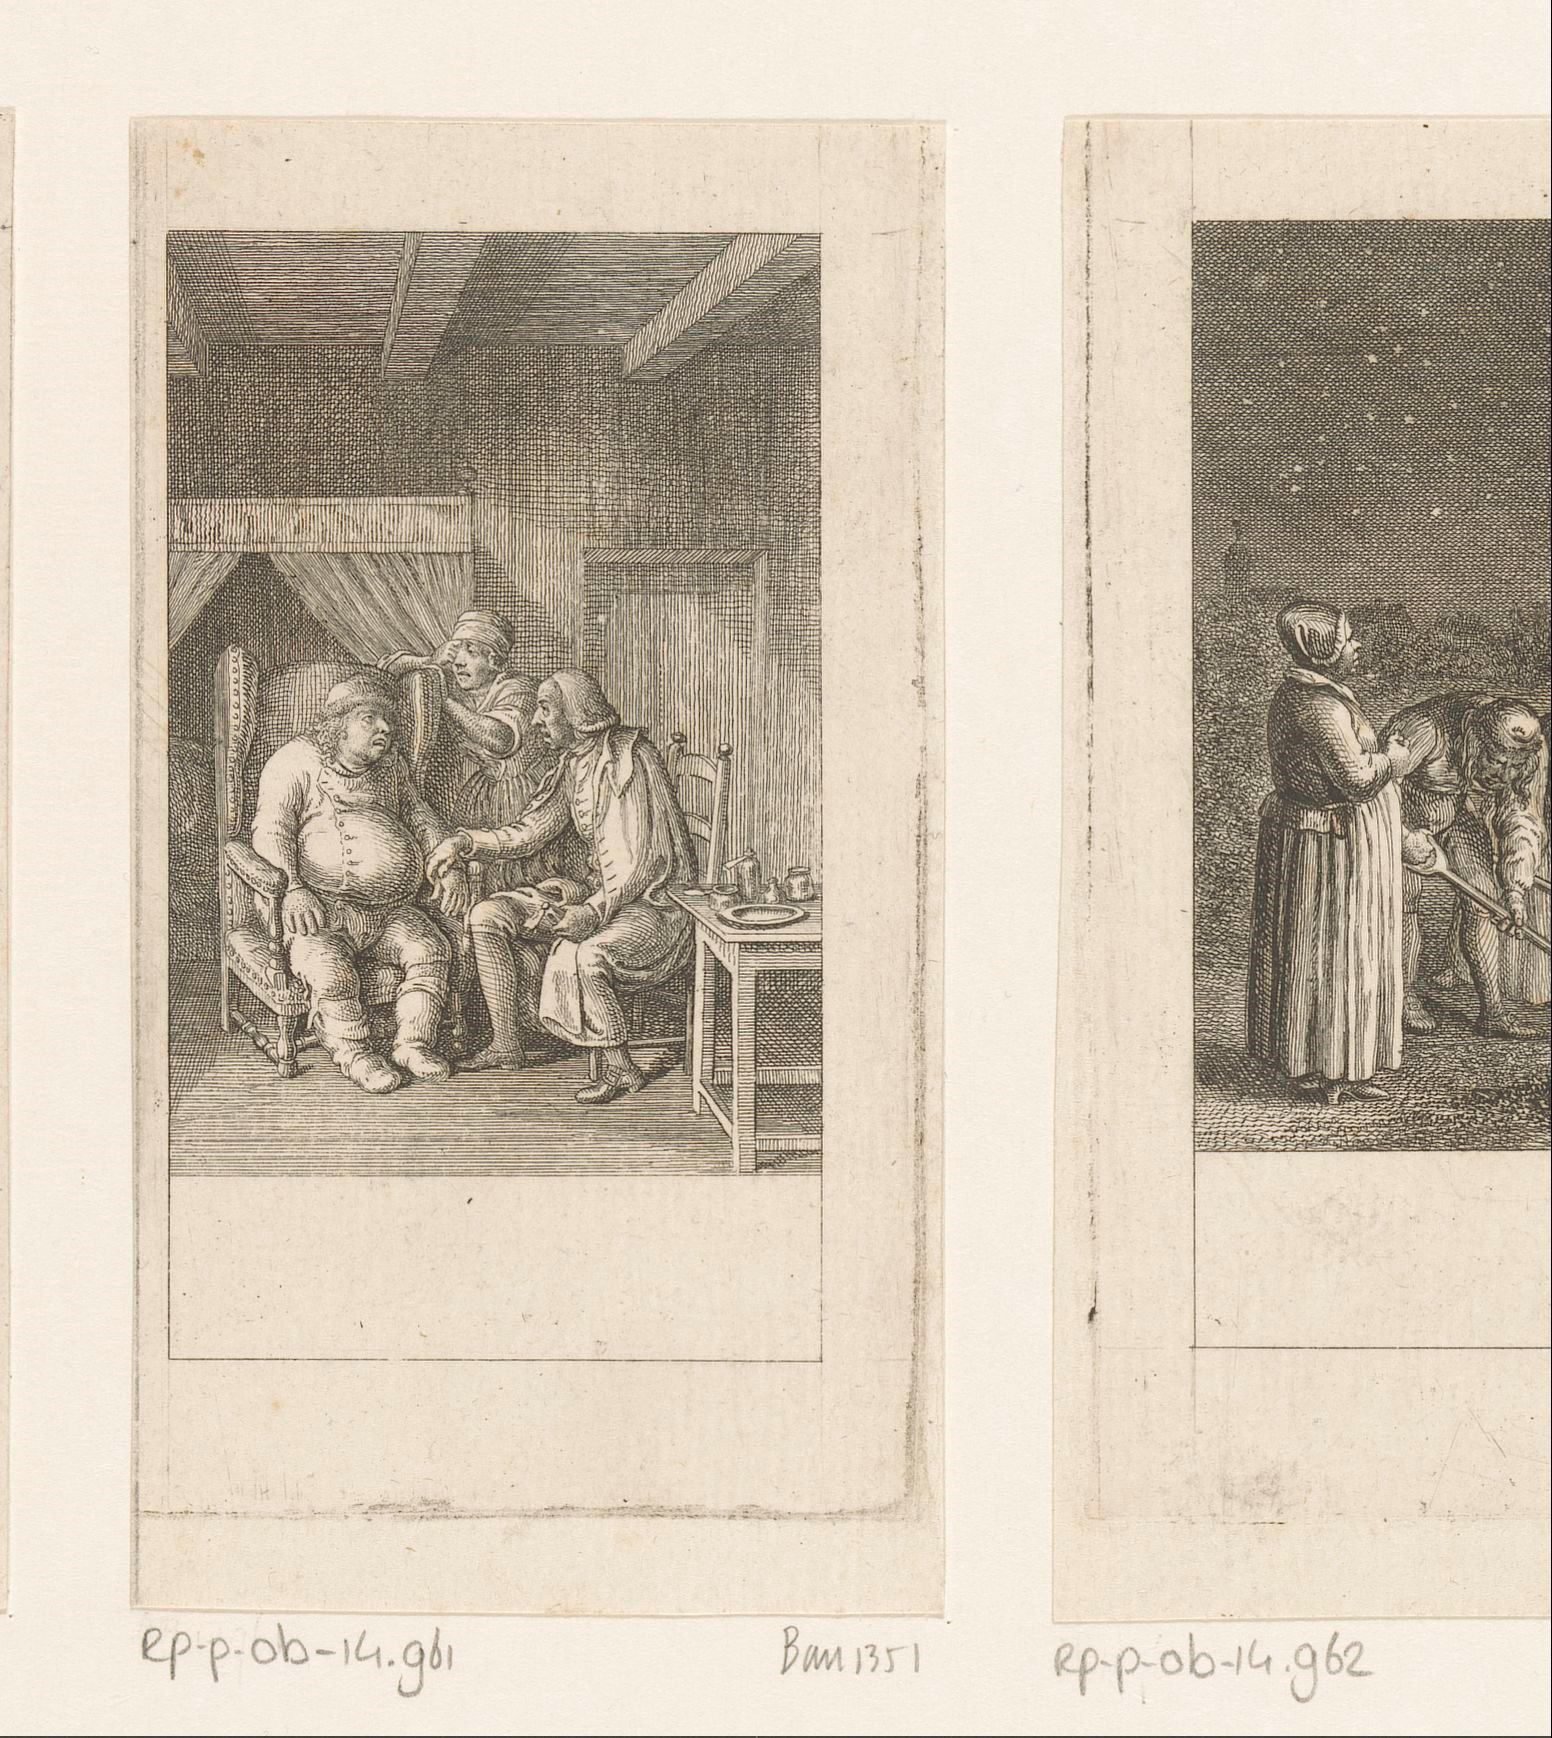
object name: print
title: Wonderdokter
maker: daniel nikolaus chodowiecki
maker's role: draughtsman, print maker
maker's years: 1726-1801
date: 1788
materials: paper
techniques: etching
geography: berlin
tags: quack, charlatan, mountebank, 'saltimbanco', physician, doctor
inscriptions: collector's mark: Lugt 2228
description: Vervaardigd voor een serie over Duitse rages. Latere staat gebruikt voor: Berliner genealogischen Calender auf das Jahr 1789. [Berlijn]: s.n., [1788].